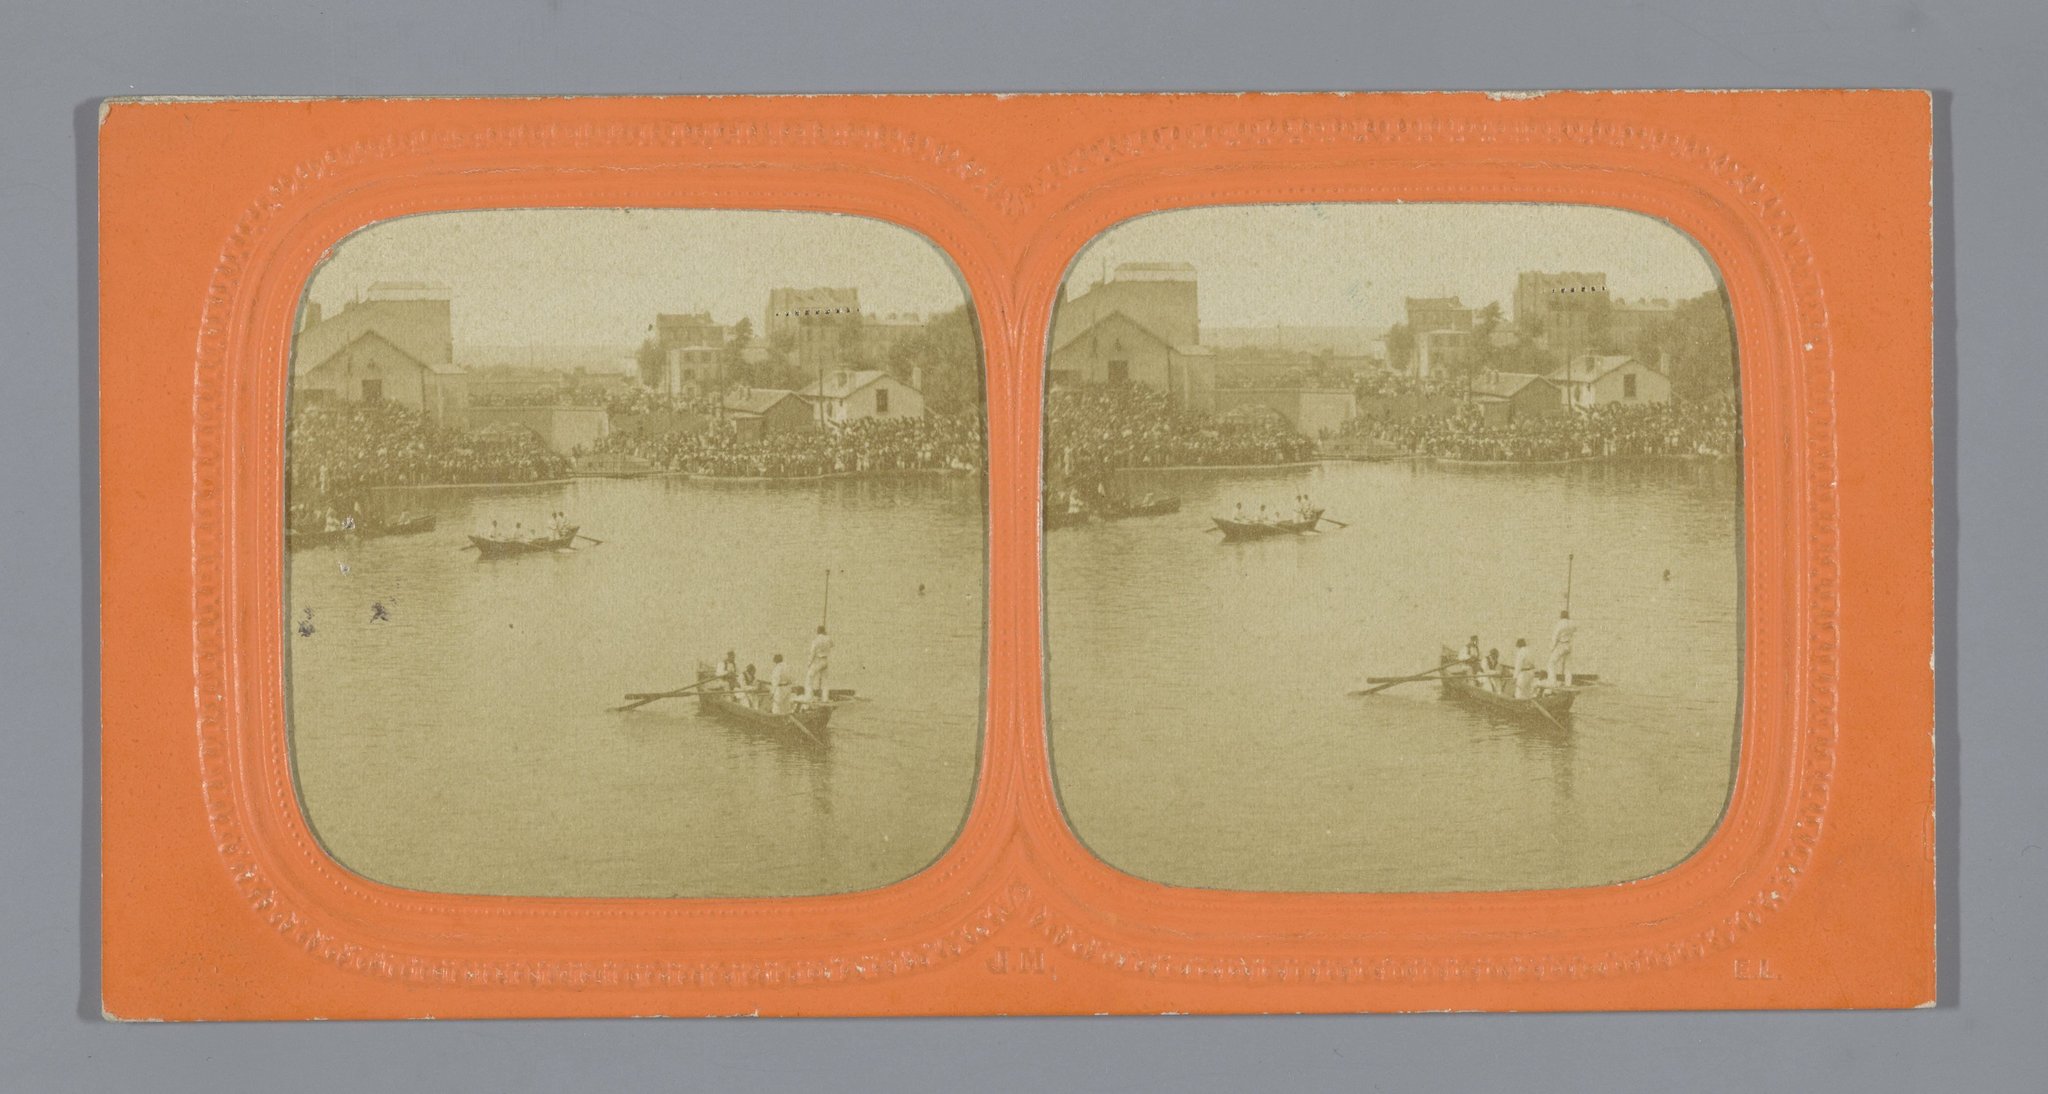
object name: tissue stereograph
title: Roeiboten op het water en publiek langs de kade, Parijs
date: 1864-1879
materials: cardboard, paper, photographic support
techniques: albumen print, hand coloring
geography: paris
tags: public festivities - aa - festivities on the water, rowing, canoeing, etc. (sport), paris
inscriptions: monogram: ‘E.L.’, monogram: ‘J.M.’